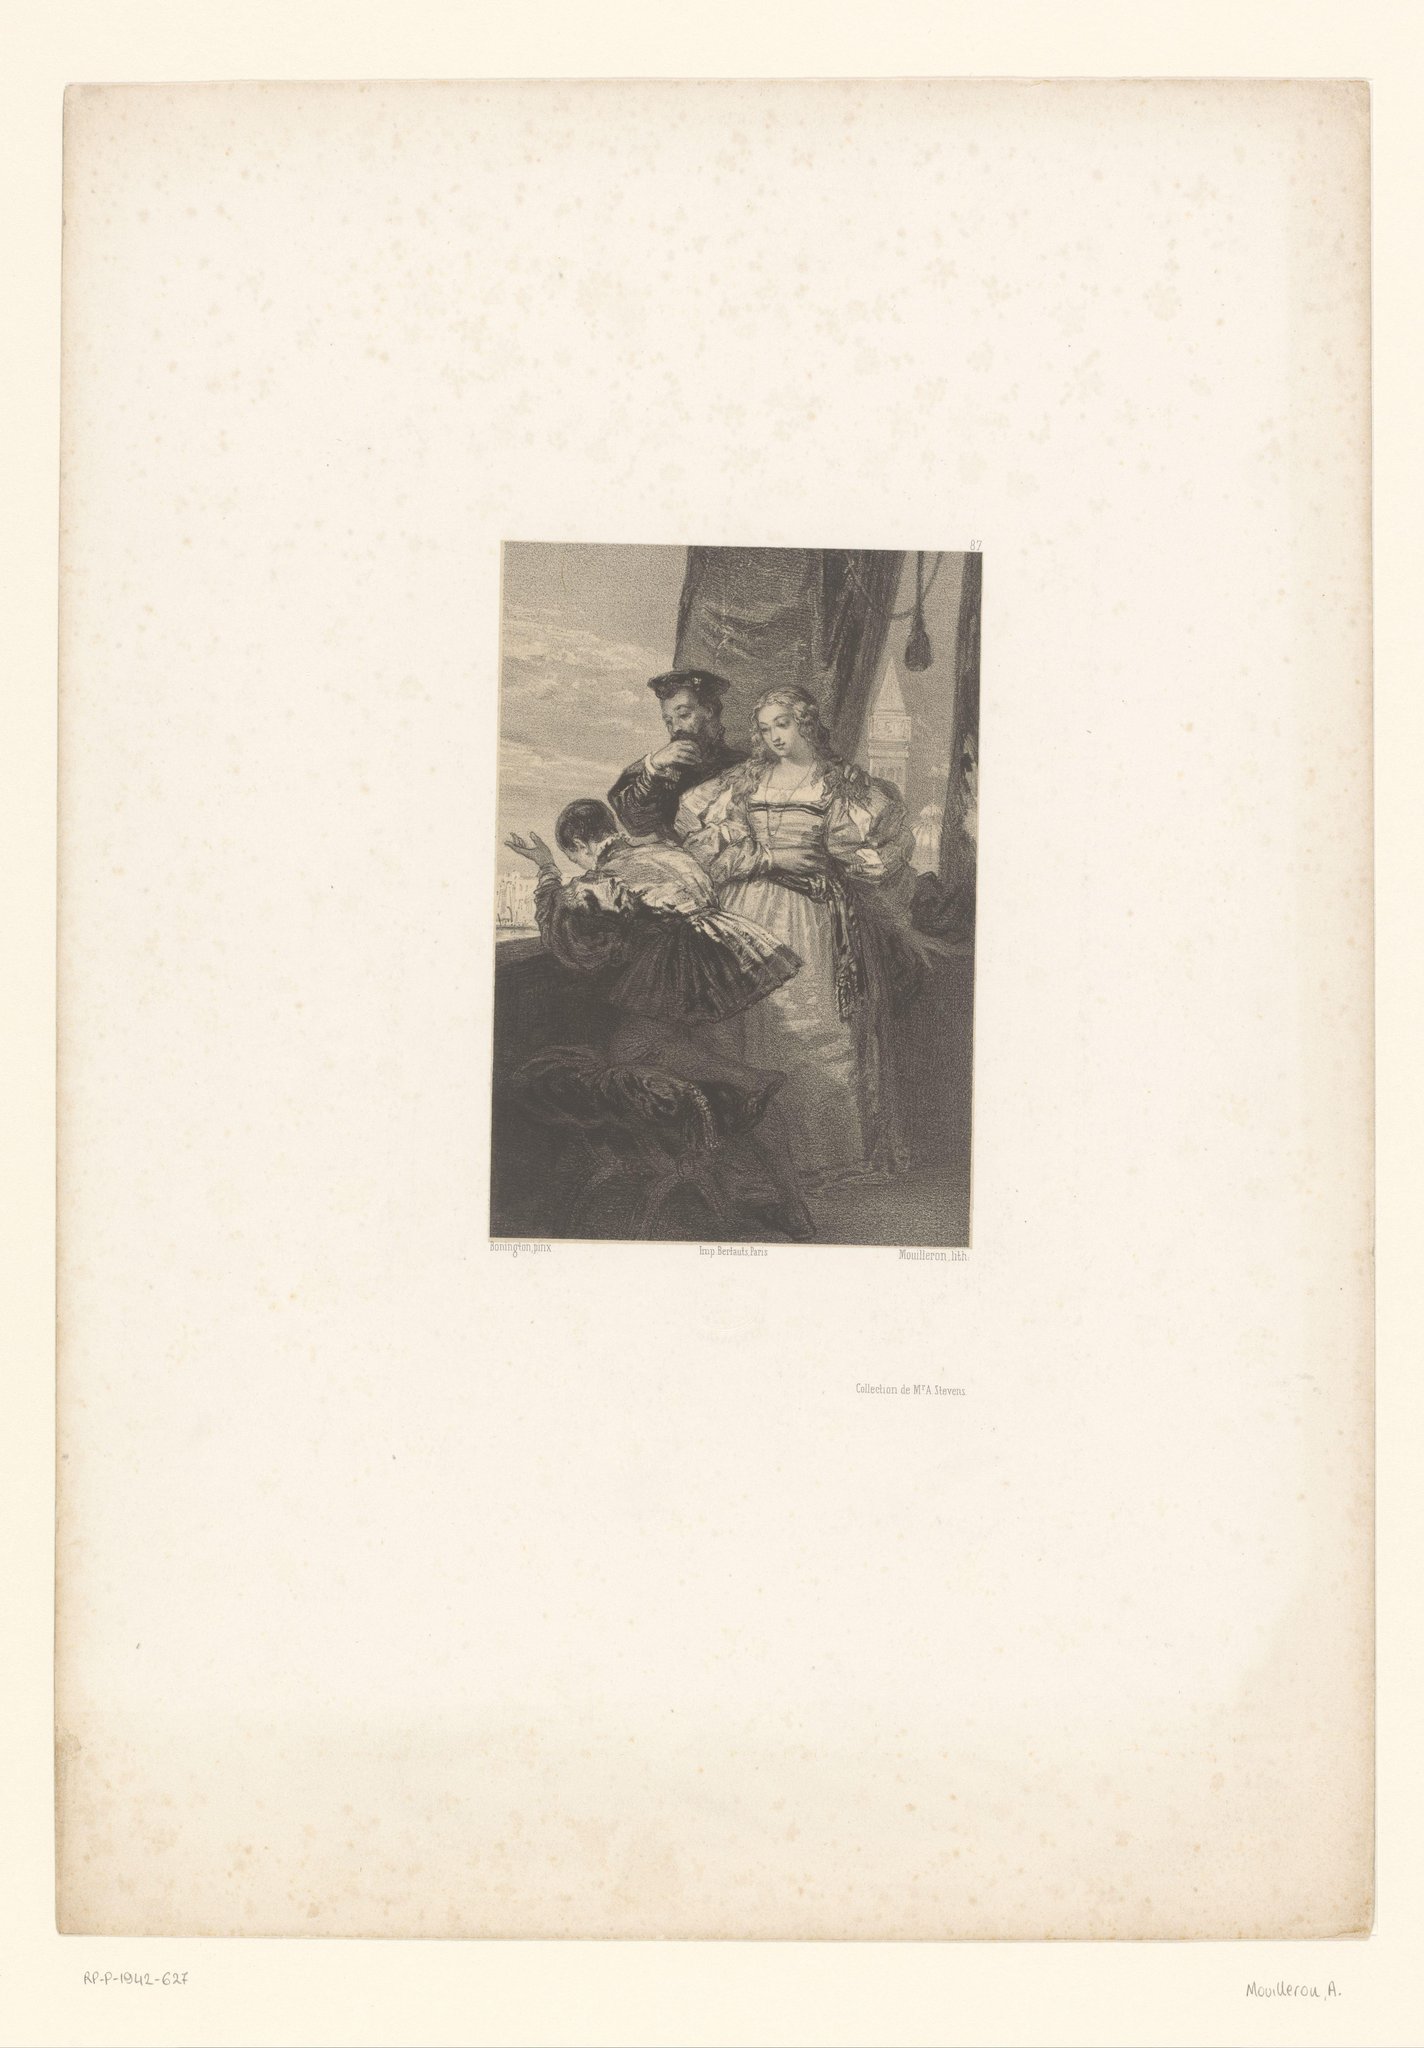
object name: print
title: Oude en hedendaagse kunstenaars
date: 1848-1862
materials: paper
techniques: lithograph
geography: paris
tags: adult man (+ two persons), balcony, venice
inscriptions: check stamp: Lugt 36a, collector's mark: Lugt 2228